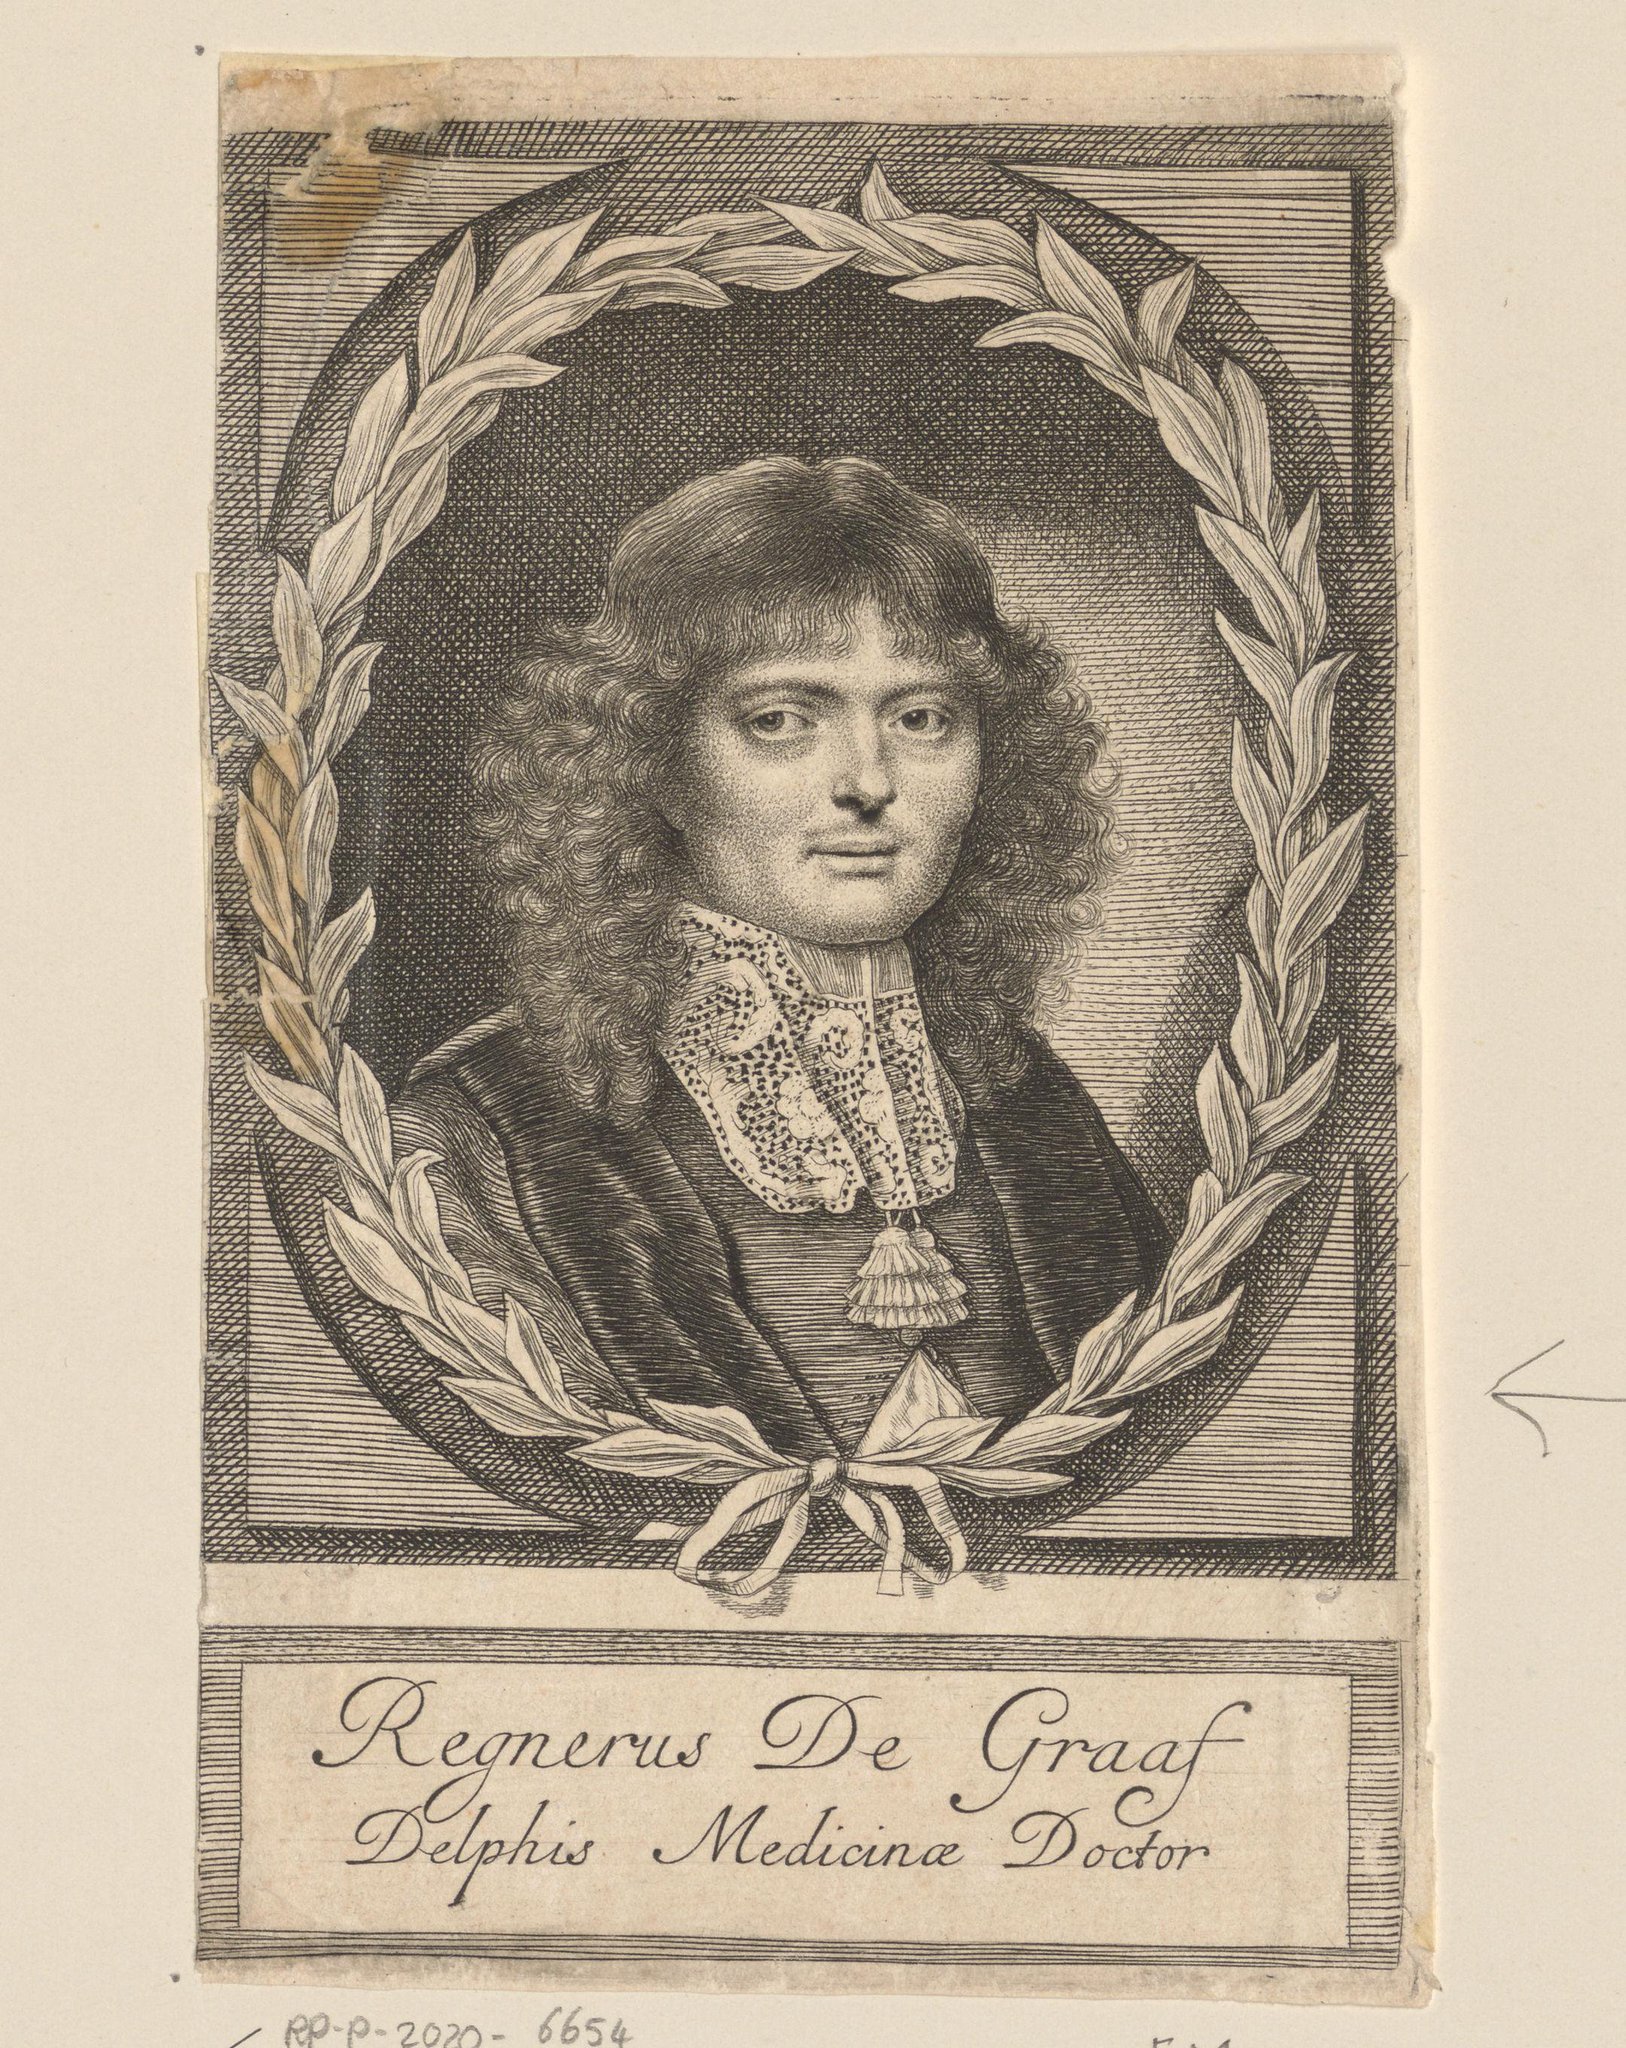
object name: print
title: Portret van Reinier de Graaf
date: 1668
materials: paper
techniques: engraving, etching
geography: leiden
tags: delft, reinier de graaf, historical persons, writer, poet, author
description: Prent waarschijnlijk uit: Graaf, Reinier de. De Virorum organis generationi inservientibus, de clysteribus et de usu siphonis in Anatomia. Leiden: Franciscus Hackius, 1668.